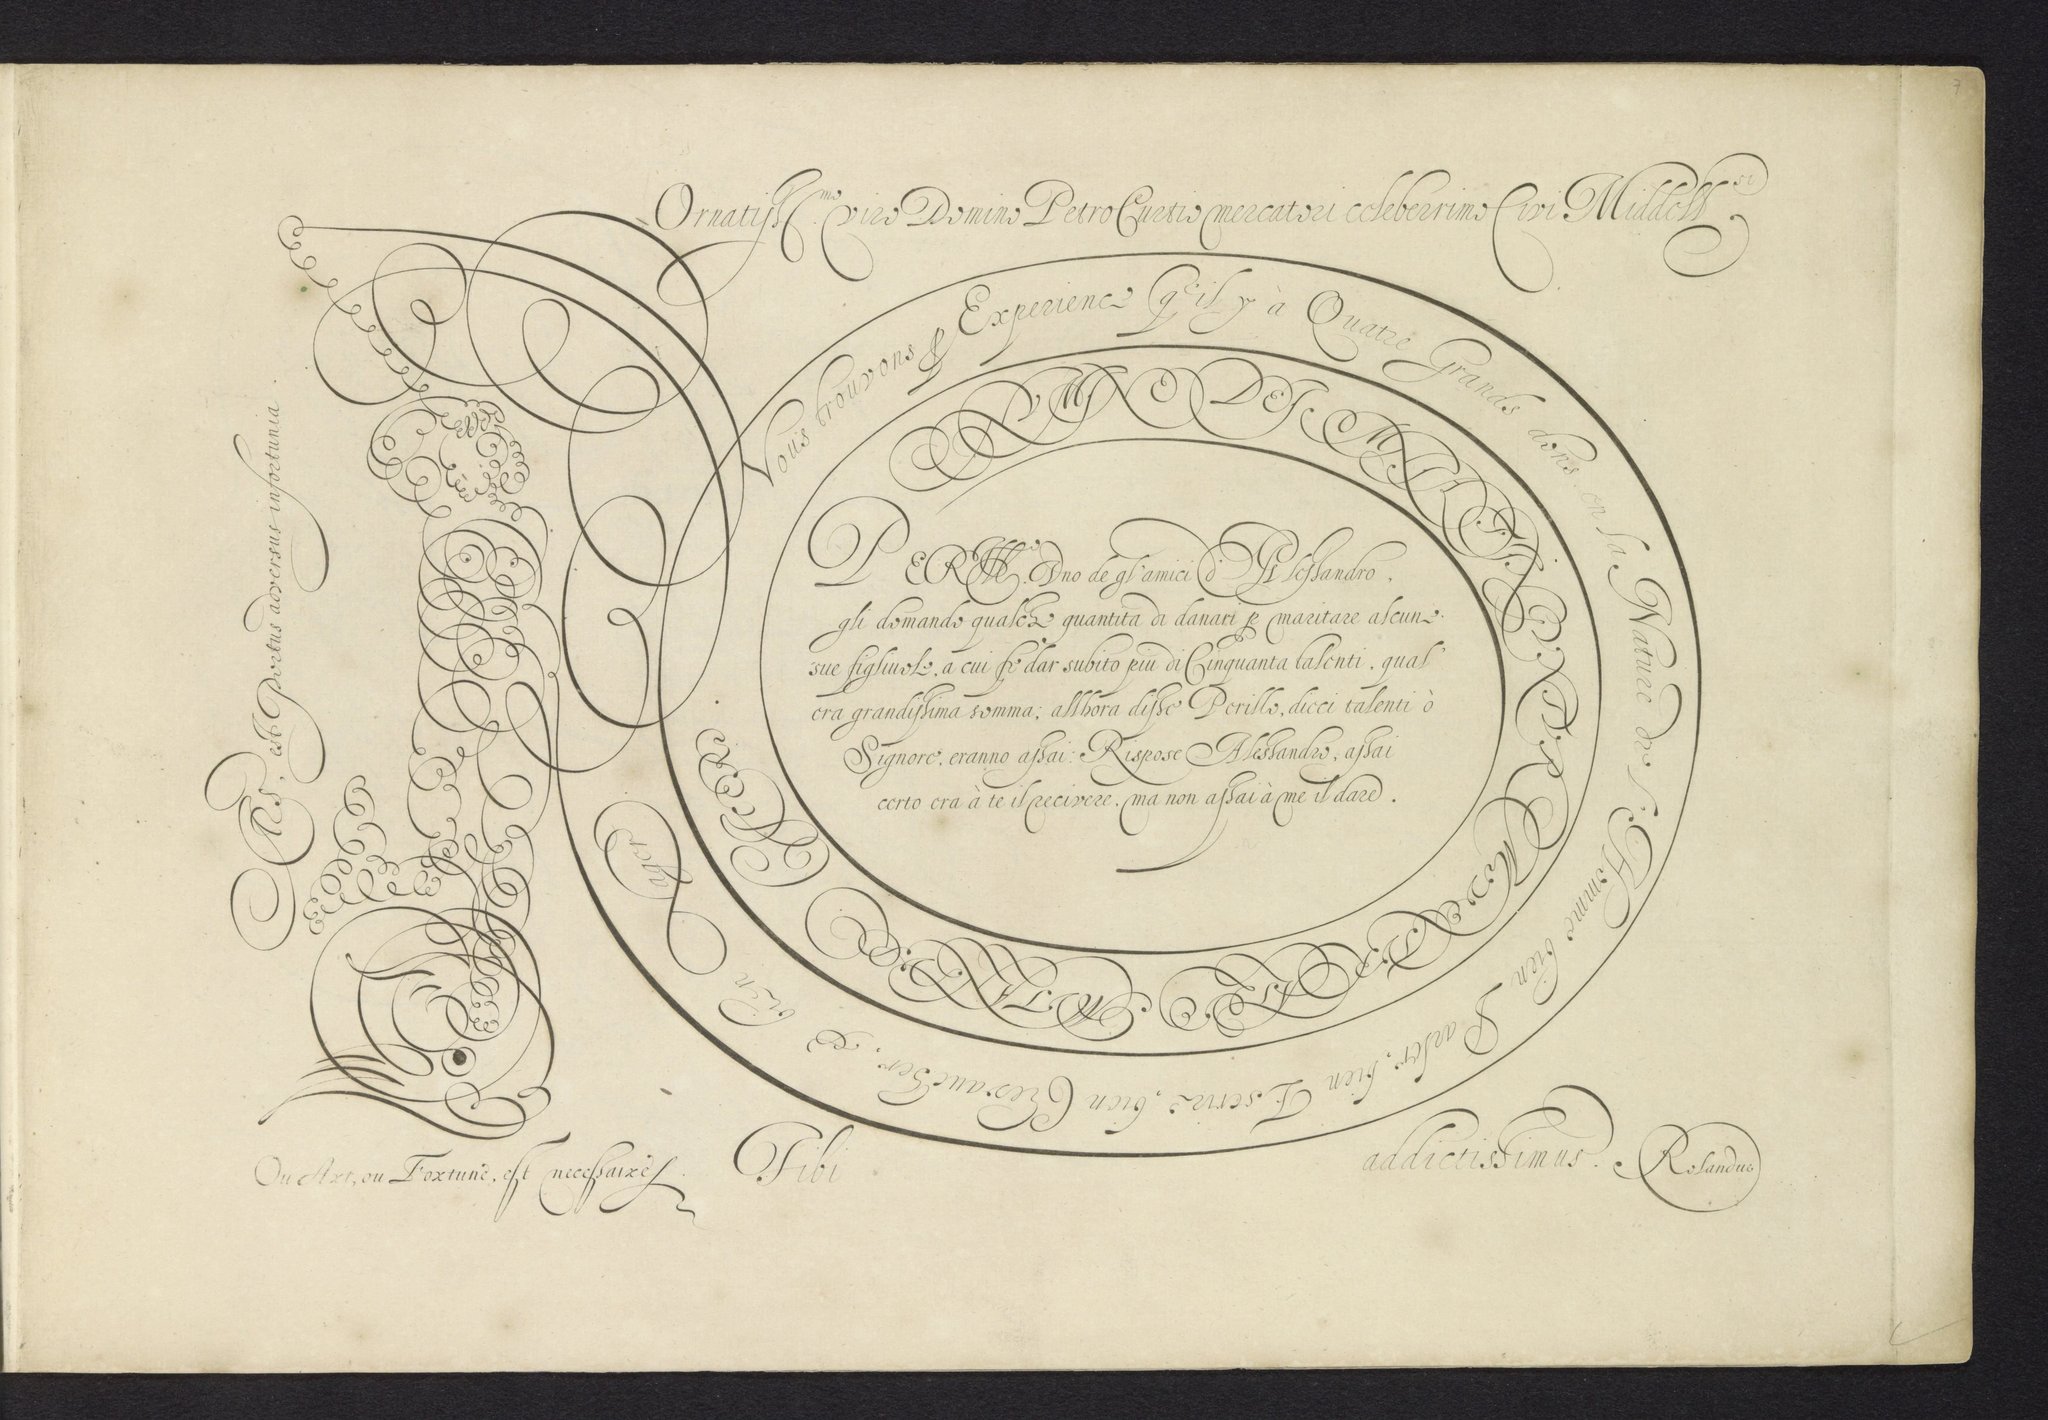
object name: ornament print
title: 't Magazin oft pac-huys der loffelycker penn-const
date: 1616-1617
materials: paper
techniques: engraving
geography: flushing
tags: calligraphy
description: Schrijfvoorbeeld met Fortuna staande op een vis en met een zeil in haar handen, in krulwerk. Daarbij zes regels tekst in het Italiaans: Per ill uno de gl'amici d'Alessandro en een tekst in een spiraal geschreven. Bovenaan een opdracht aan Pieter Courten, koopman in Middelburg. De prent maakt deel uit van een album getiteld: Prijs boek van Jan Malnoe.